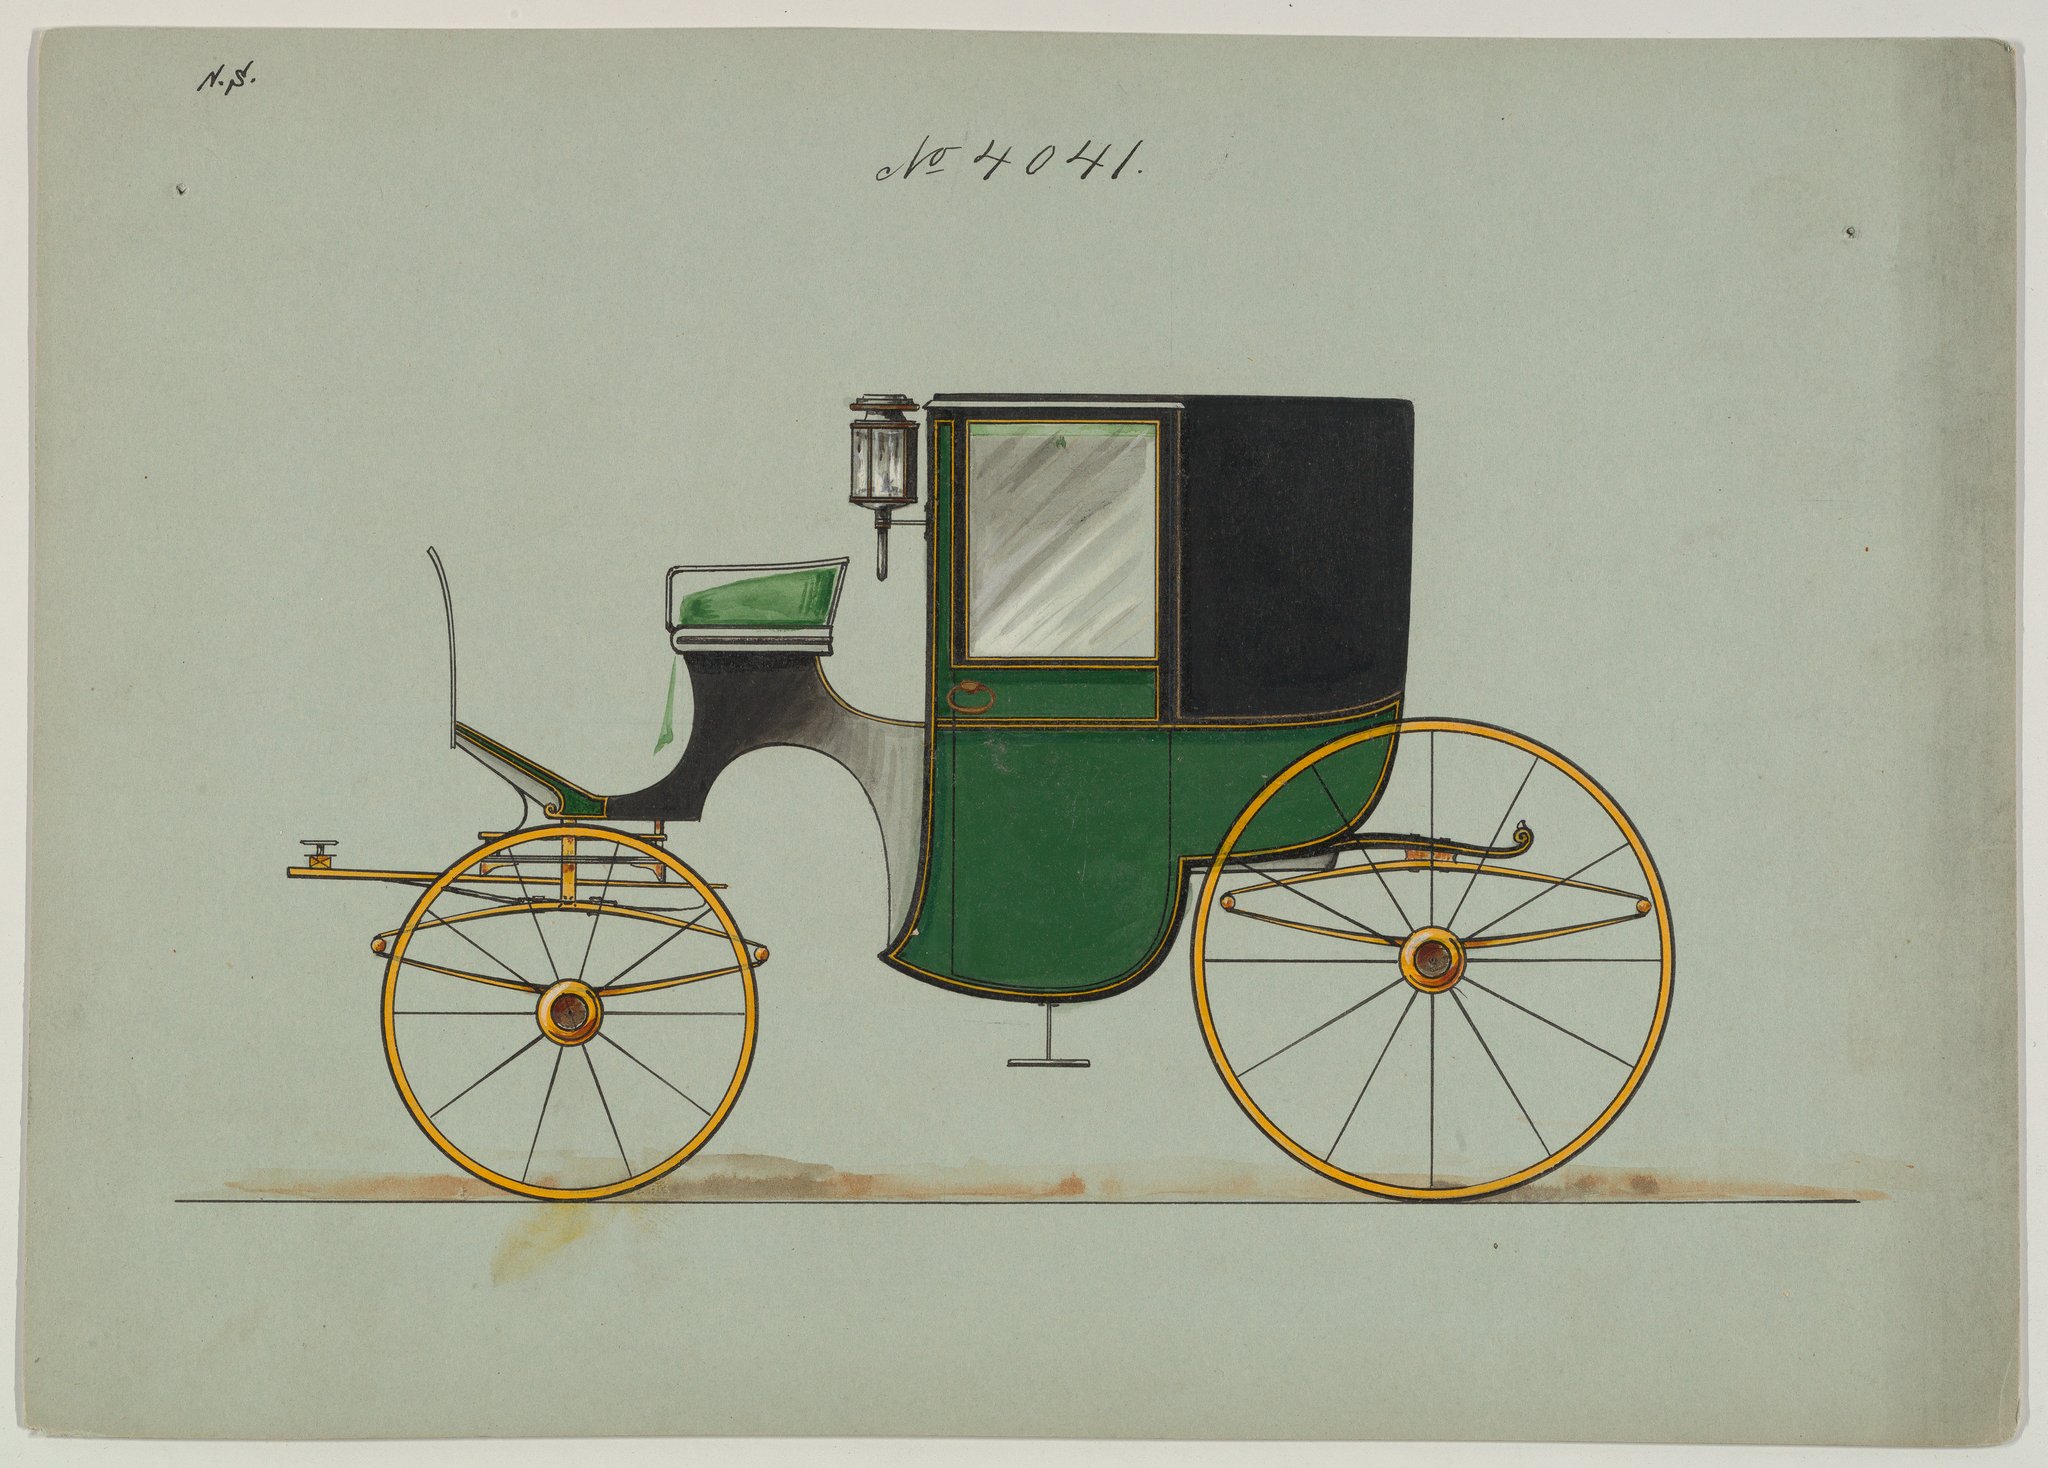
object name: drawing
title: Brougham #4041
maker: brewster & co.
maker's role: manufacturer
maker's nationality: american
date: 1889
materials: gouache, gum arabic, ink, watercolor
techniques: pen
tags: carriages